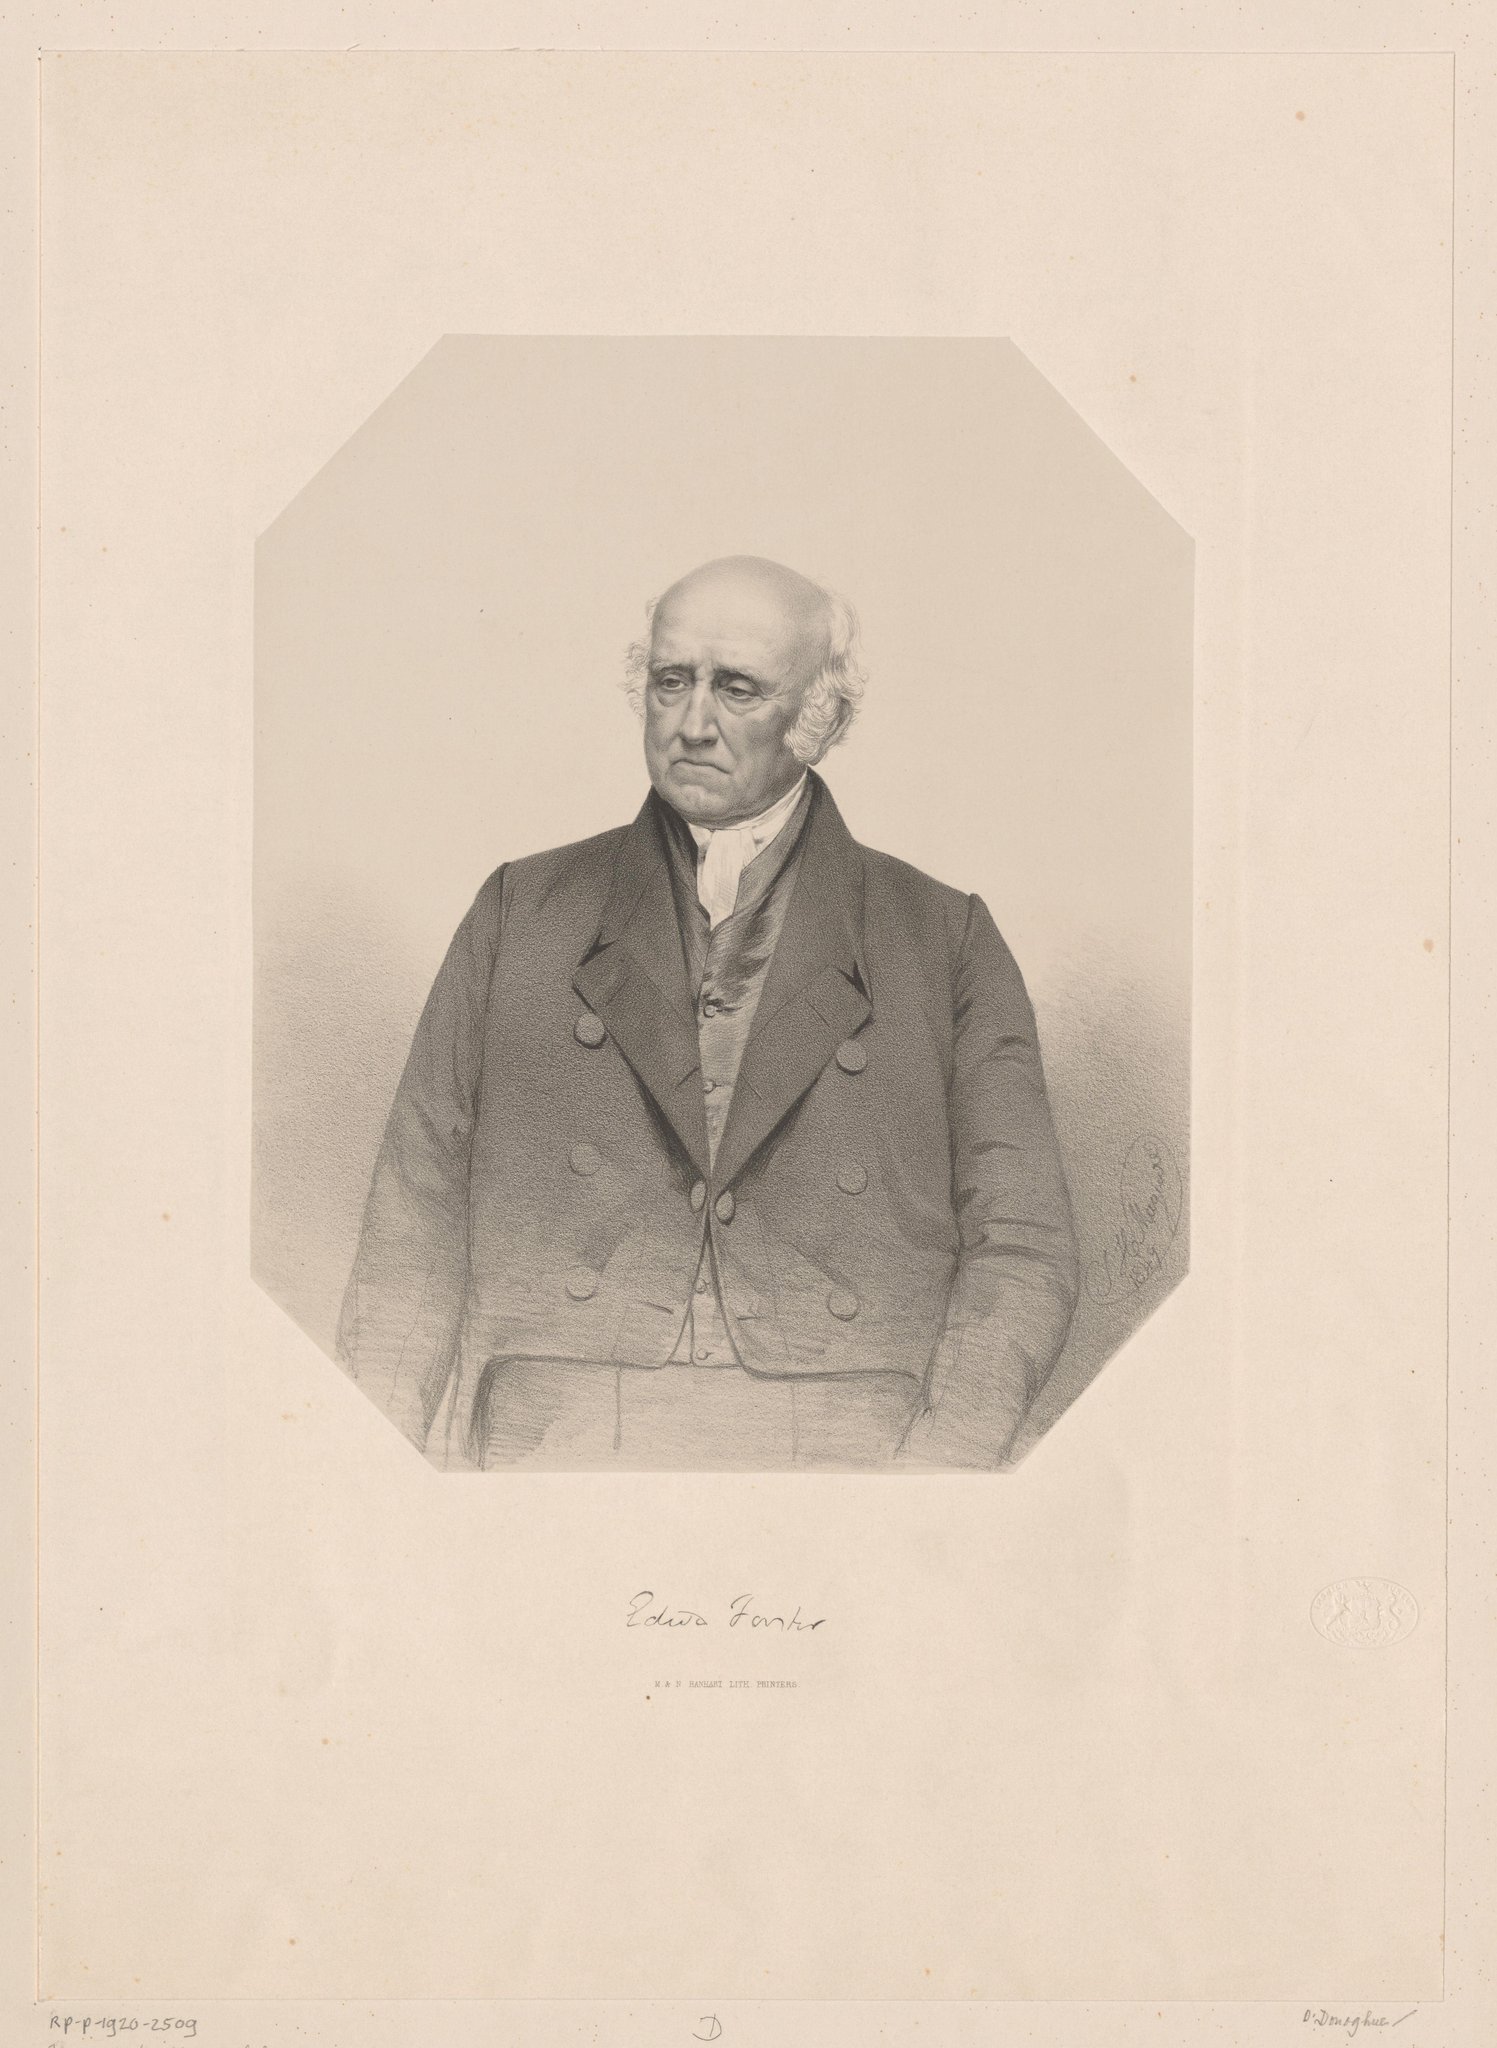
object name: print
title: Ipswich Museum Portraits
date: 1849-1852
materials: paper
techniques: lithograph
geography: england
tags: botany (+ portrait of scholar, scientist), historical persons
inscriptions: check stamp: ‘Ipswich Museum’, inscription: ‘l. sc’, collector's mark: Lugt 2228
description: De prenten werden door Maguire tussen 1848 en 1852 gemaakt en in 1852 uitgegeven door George Ransome ter herinnering aan de oprichting van het Ipswich Museum. De serie is ook bekend onder de titel 'Portraits of Honorary Members of the Ipswich Museum'.